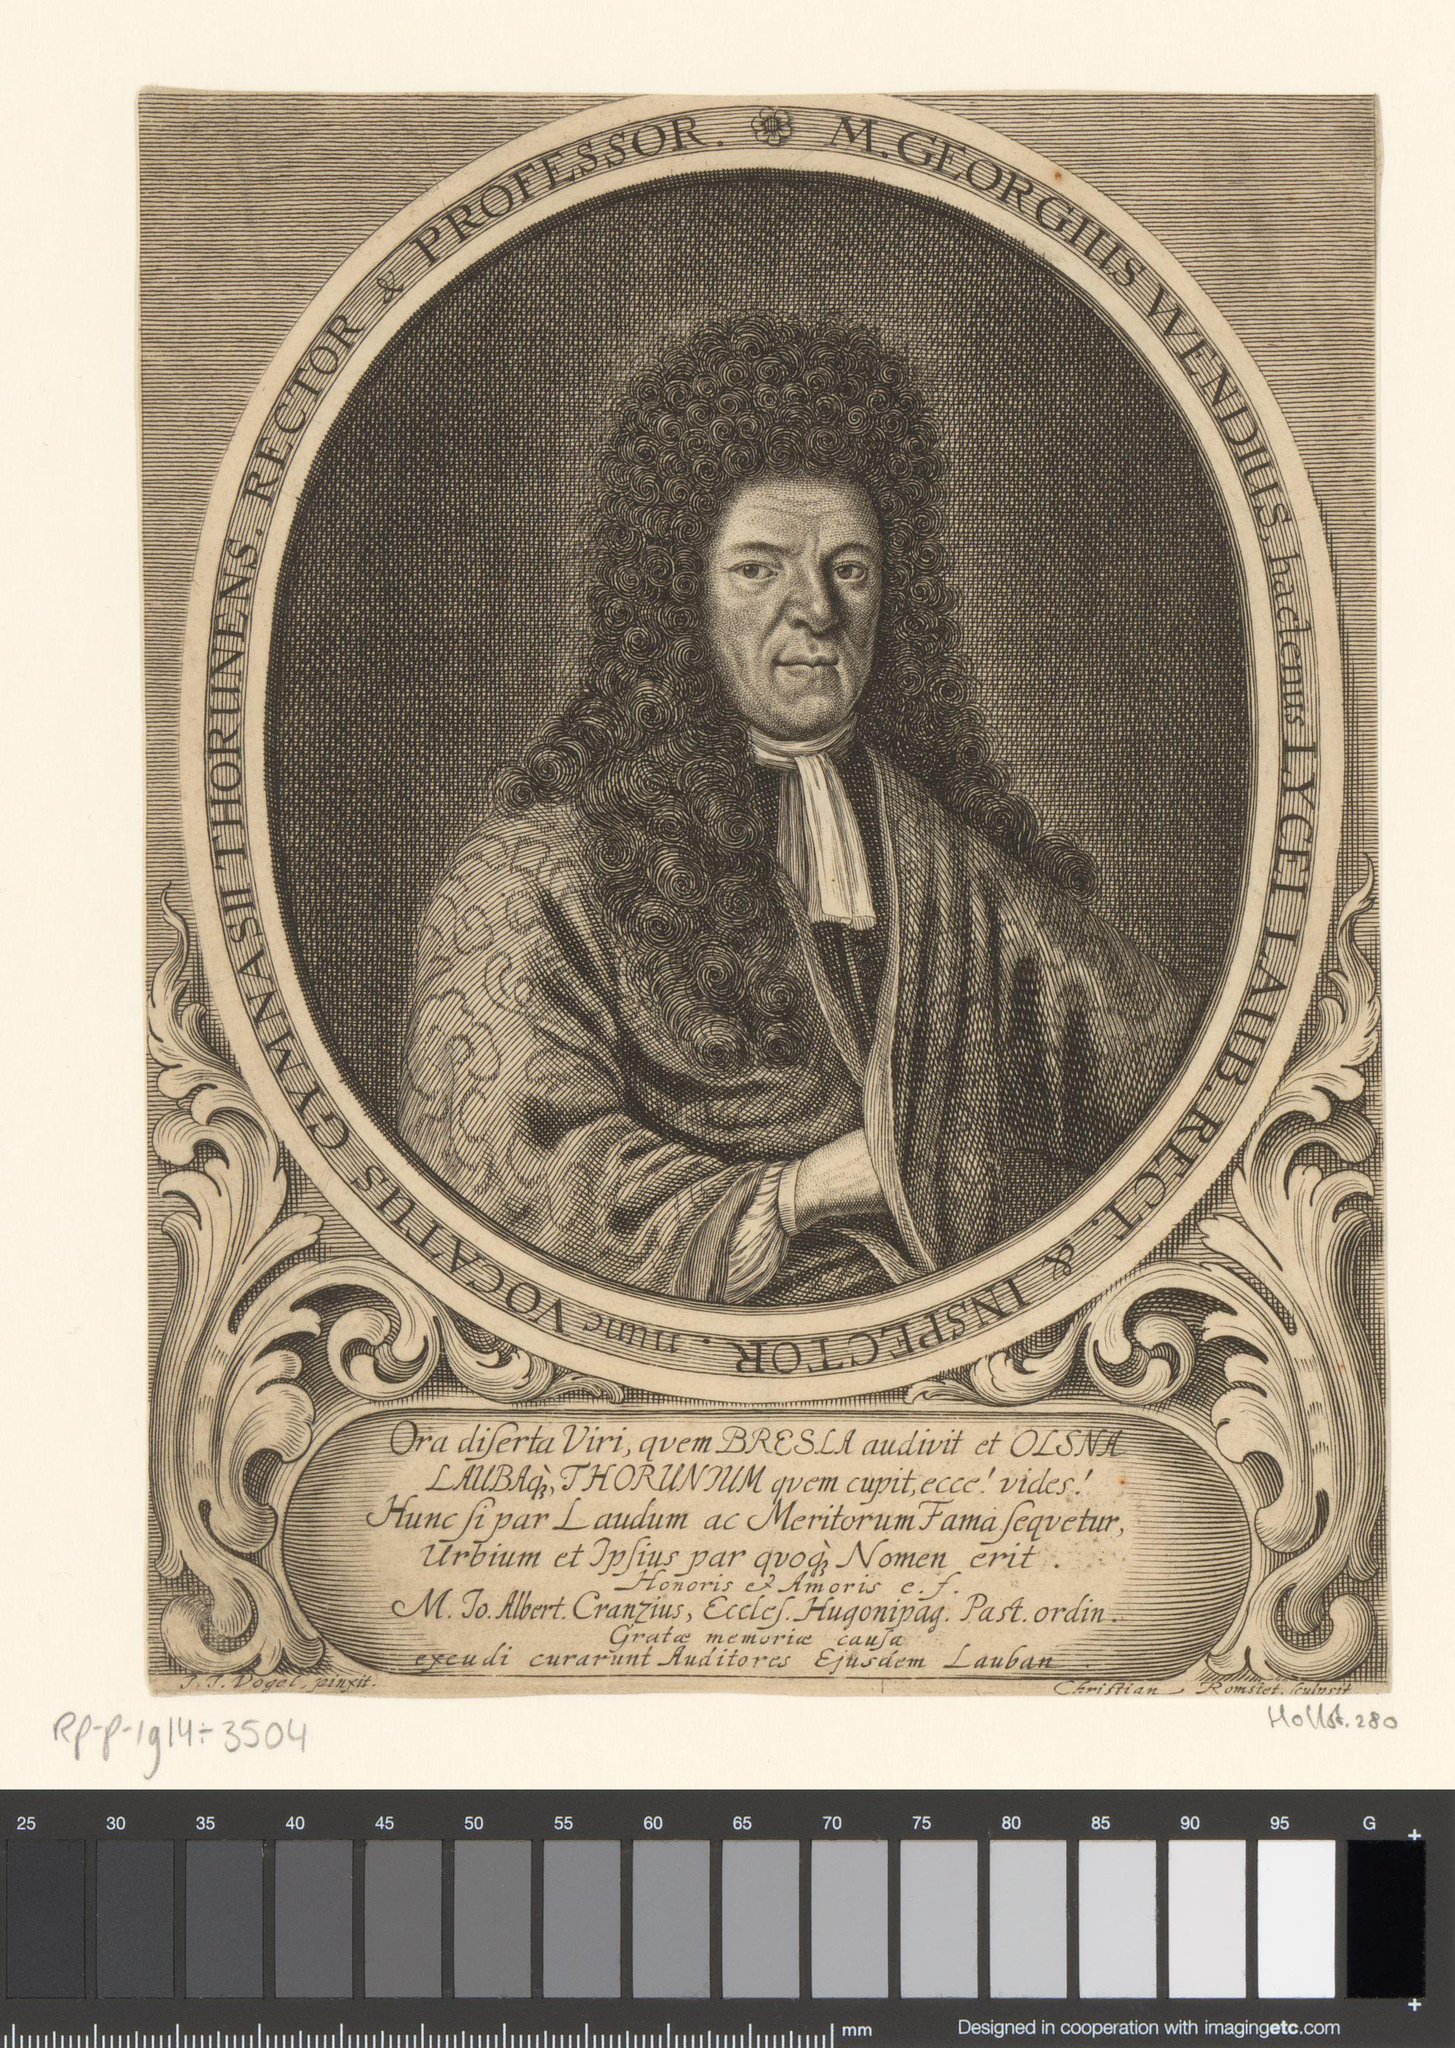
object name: print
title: Portret van Georg Wende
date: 1665-1721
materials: paper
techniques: engraving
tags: historical persons, portrait of a writer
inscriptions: collector's mark: Lugt 2228